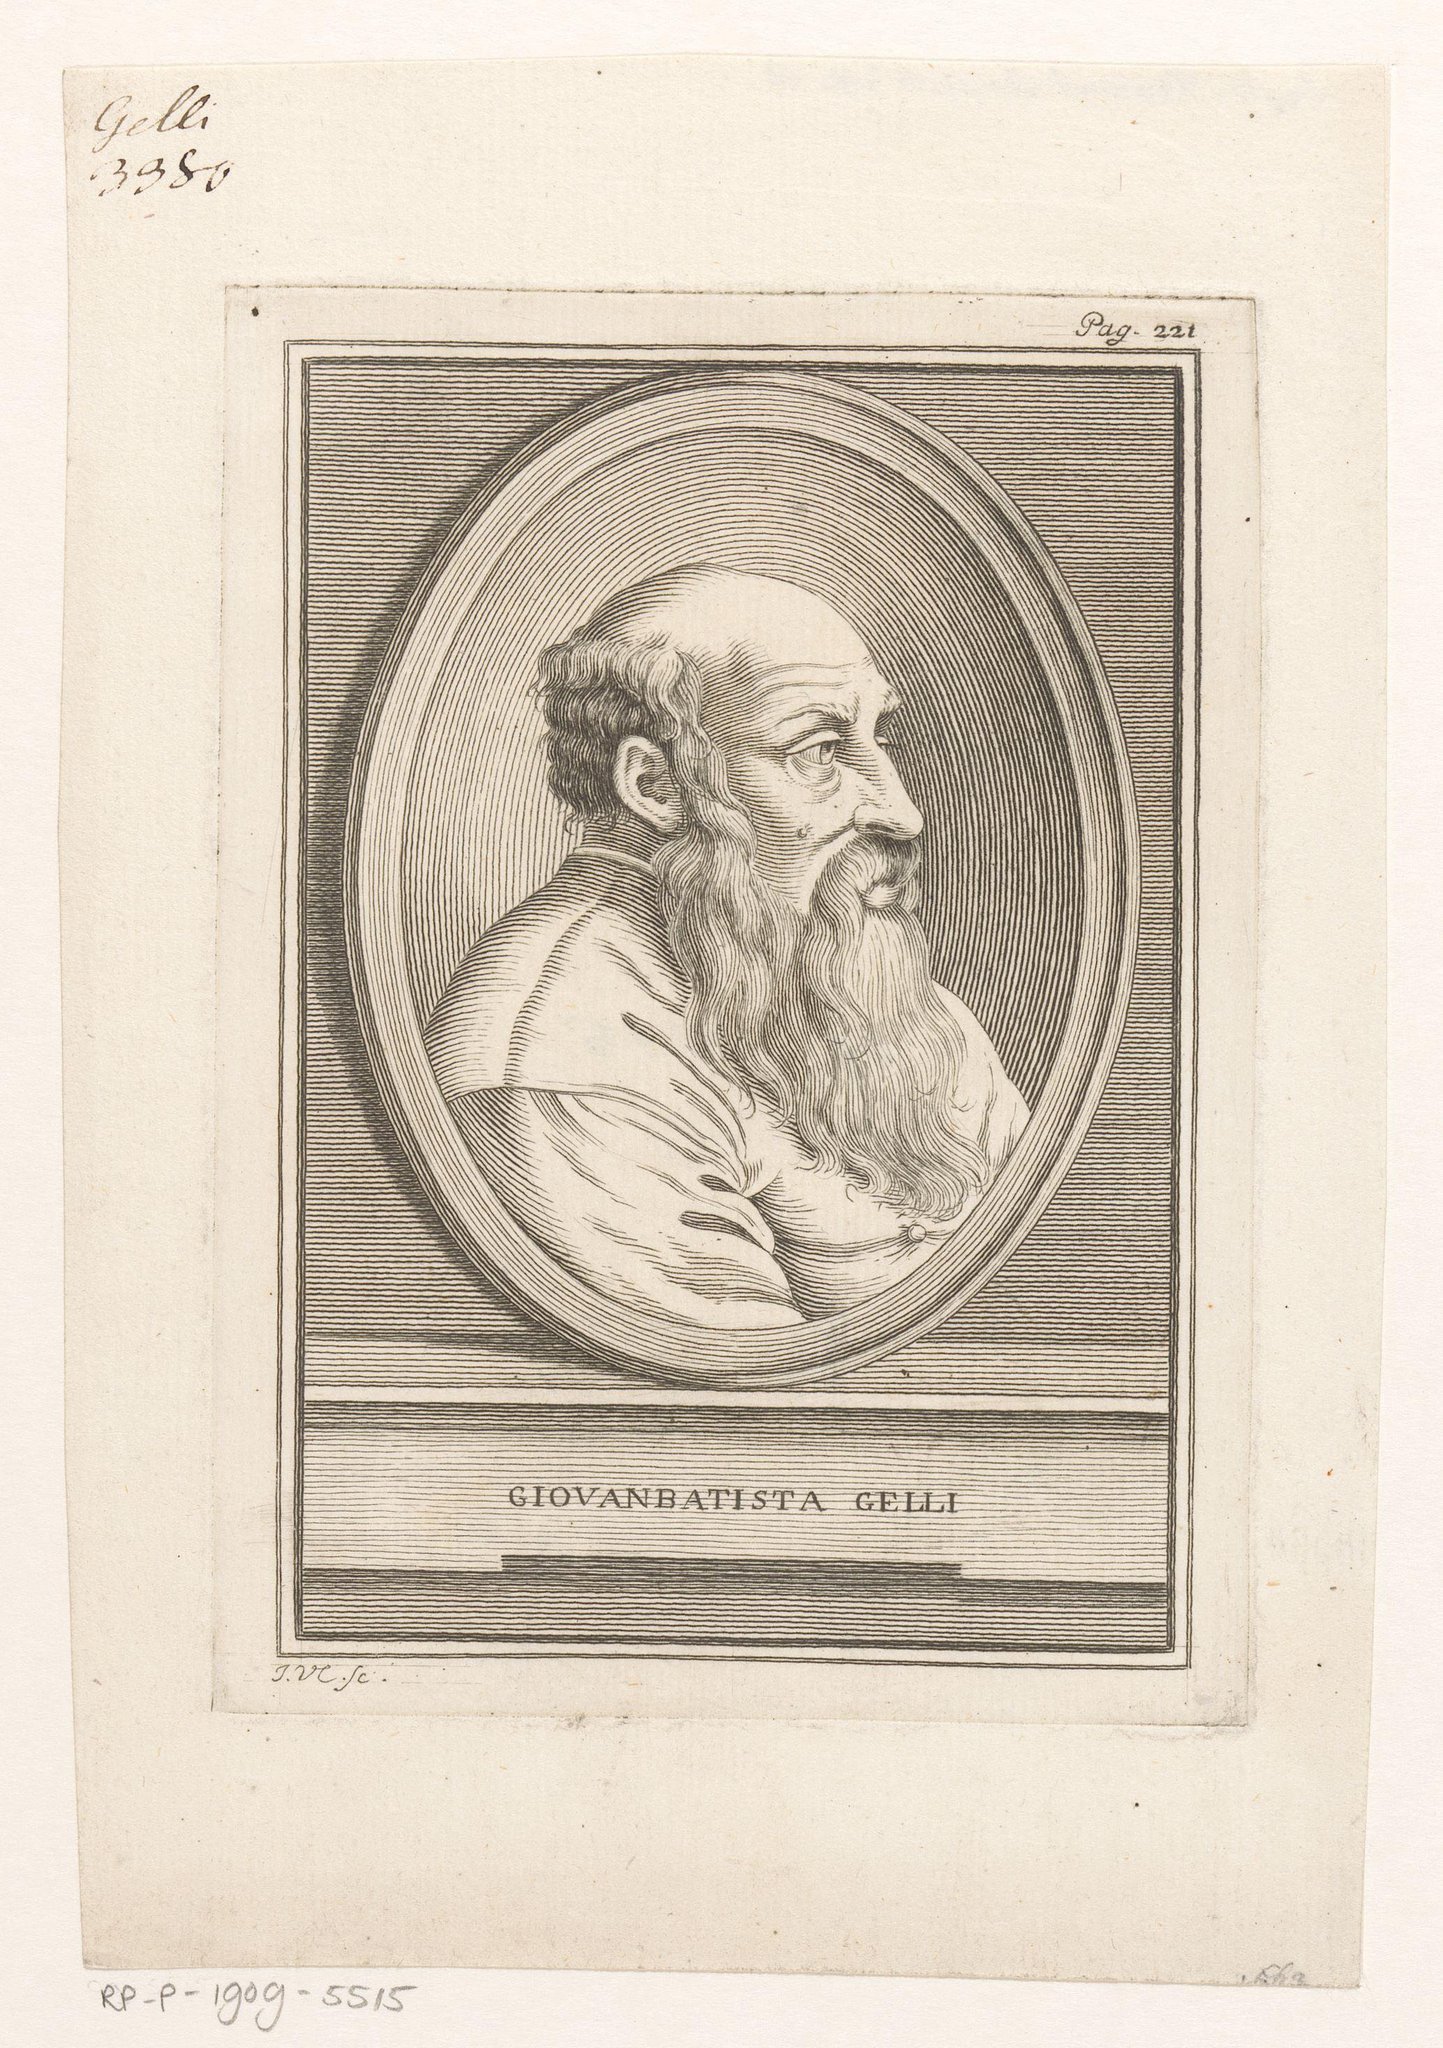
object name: print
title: Portret van liedschrijver Giovan Battista Gelli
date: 1750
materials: paper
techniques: engraving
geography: lucca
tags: historical persons, portrait of a writer, writer, poet, author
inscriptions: collector's mark: Lugt 2228, inscription: ‘Gelli / 3380’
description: Prent gebruikt voor Grazzini, Anton Francesco. Tutti i trionfi, carri, mascherate o canti carnascialeschi andati per Firenze dal tempo del Magnifico Lorenzo de' Medici fino all' anno 1559 : in questa seconda edizione corretti, con diversi MSS. collazionati, delle loro varie lezioni arricchiti, notabilmente accresciuti, e co' ritratti di ciascun poeta adornate. Lucca: Cosmopoli, 1750.